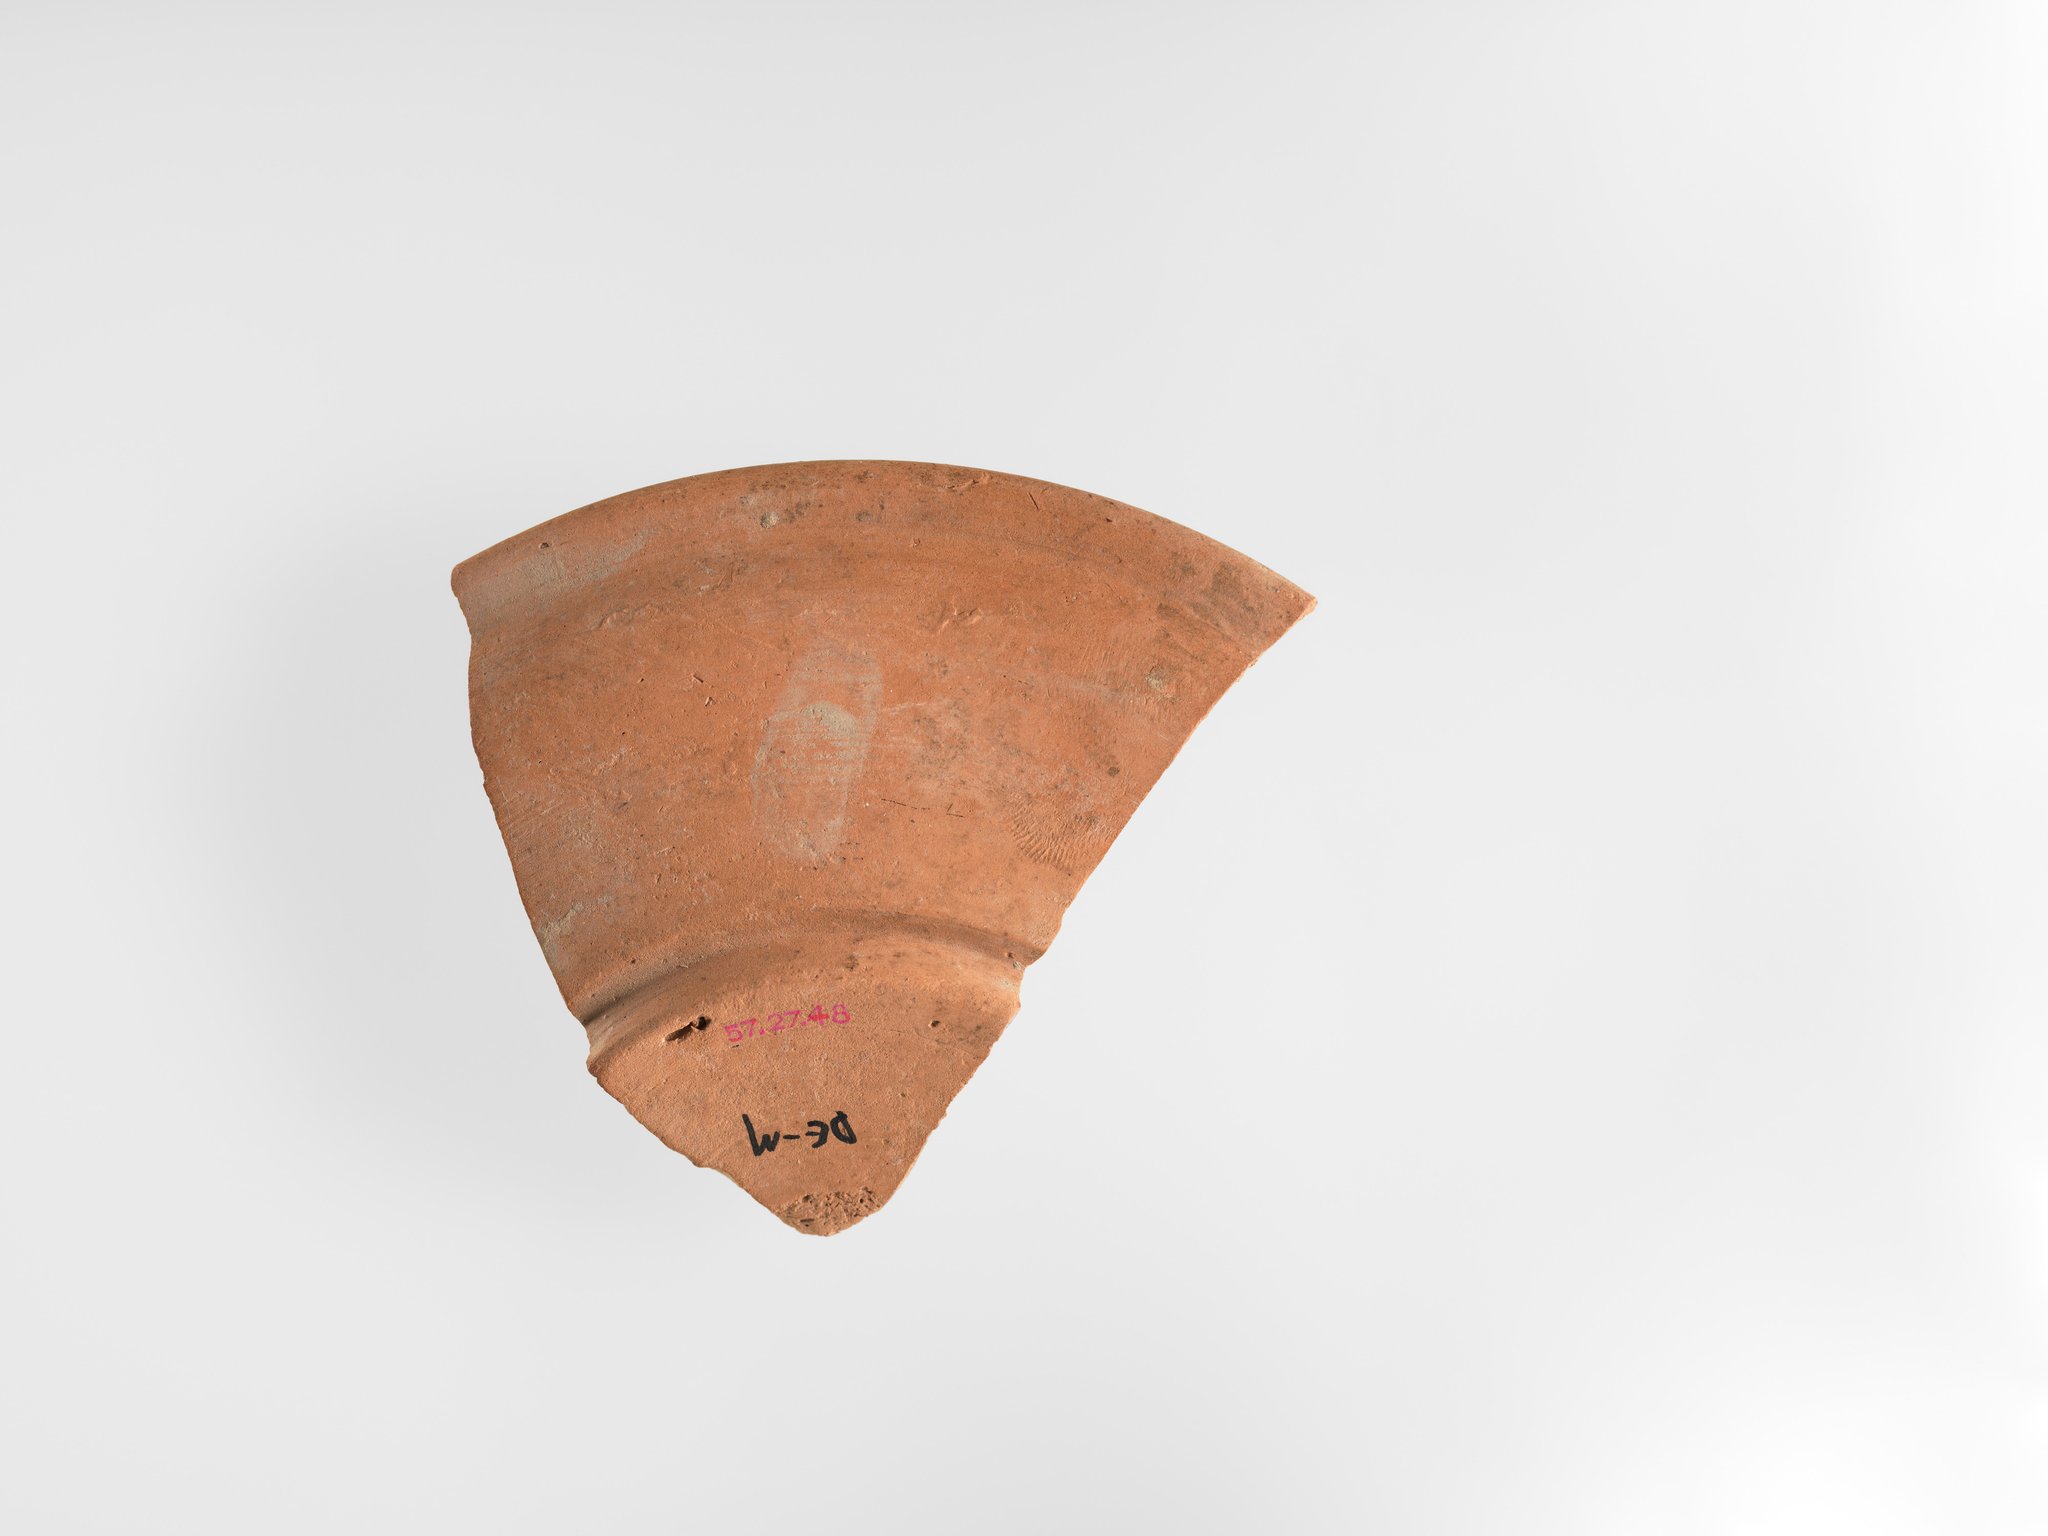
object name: bowl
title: Bowl sherd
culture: assyrian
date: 800-601 BCE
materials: ceramic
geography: mesopotamia